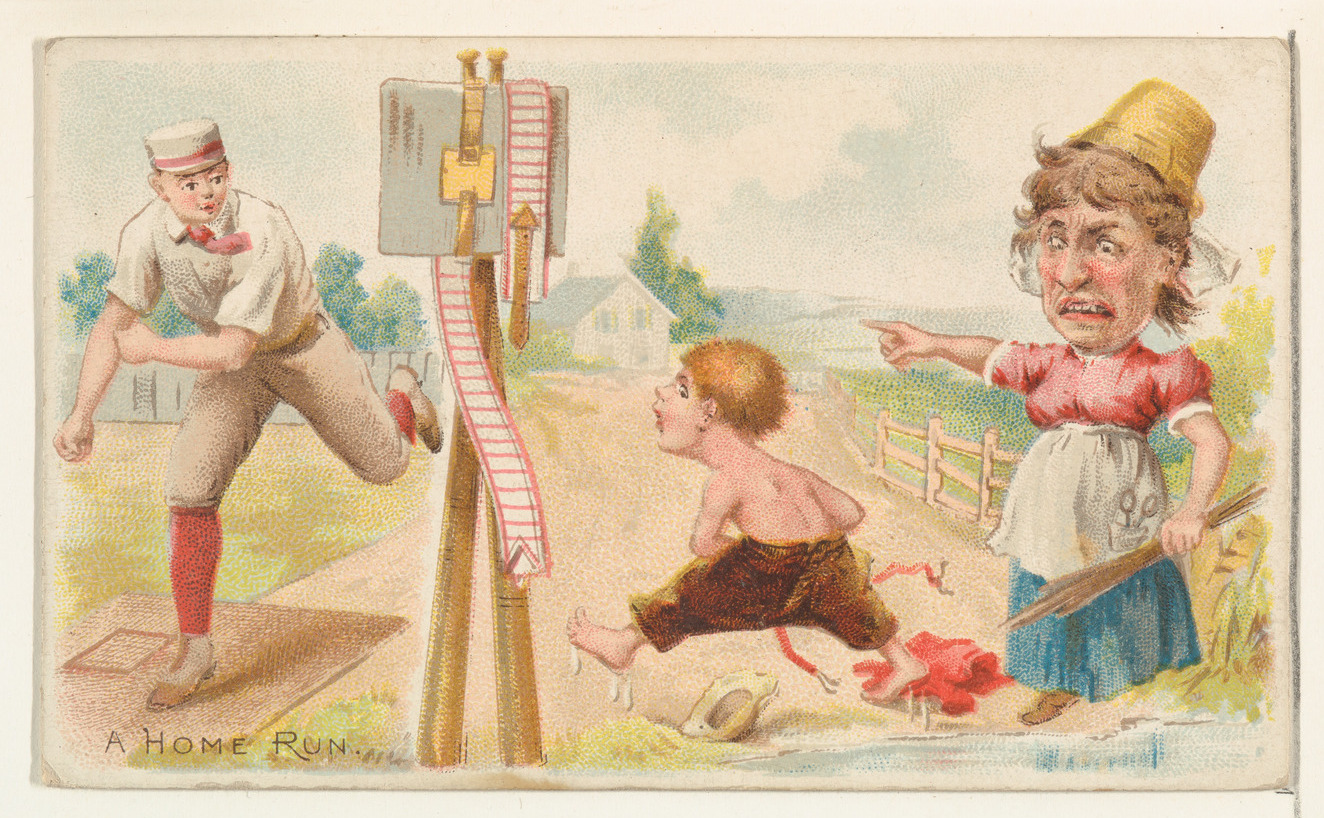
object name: print, baseball card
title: A Home Run, from the Talk of the Diamond set (N135) issued by Duke Sons & Co., a branch of the American Tobacco Company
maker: w. duke, sons & co.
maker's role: publisher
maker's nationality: american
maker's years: 1870-1920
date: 1888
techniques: color lithograph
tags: boys,men,women,baseball,athletes